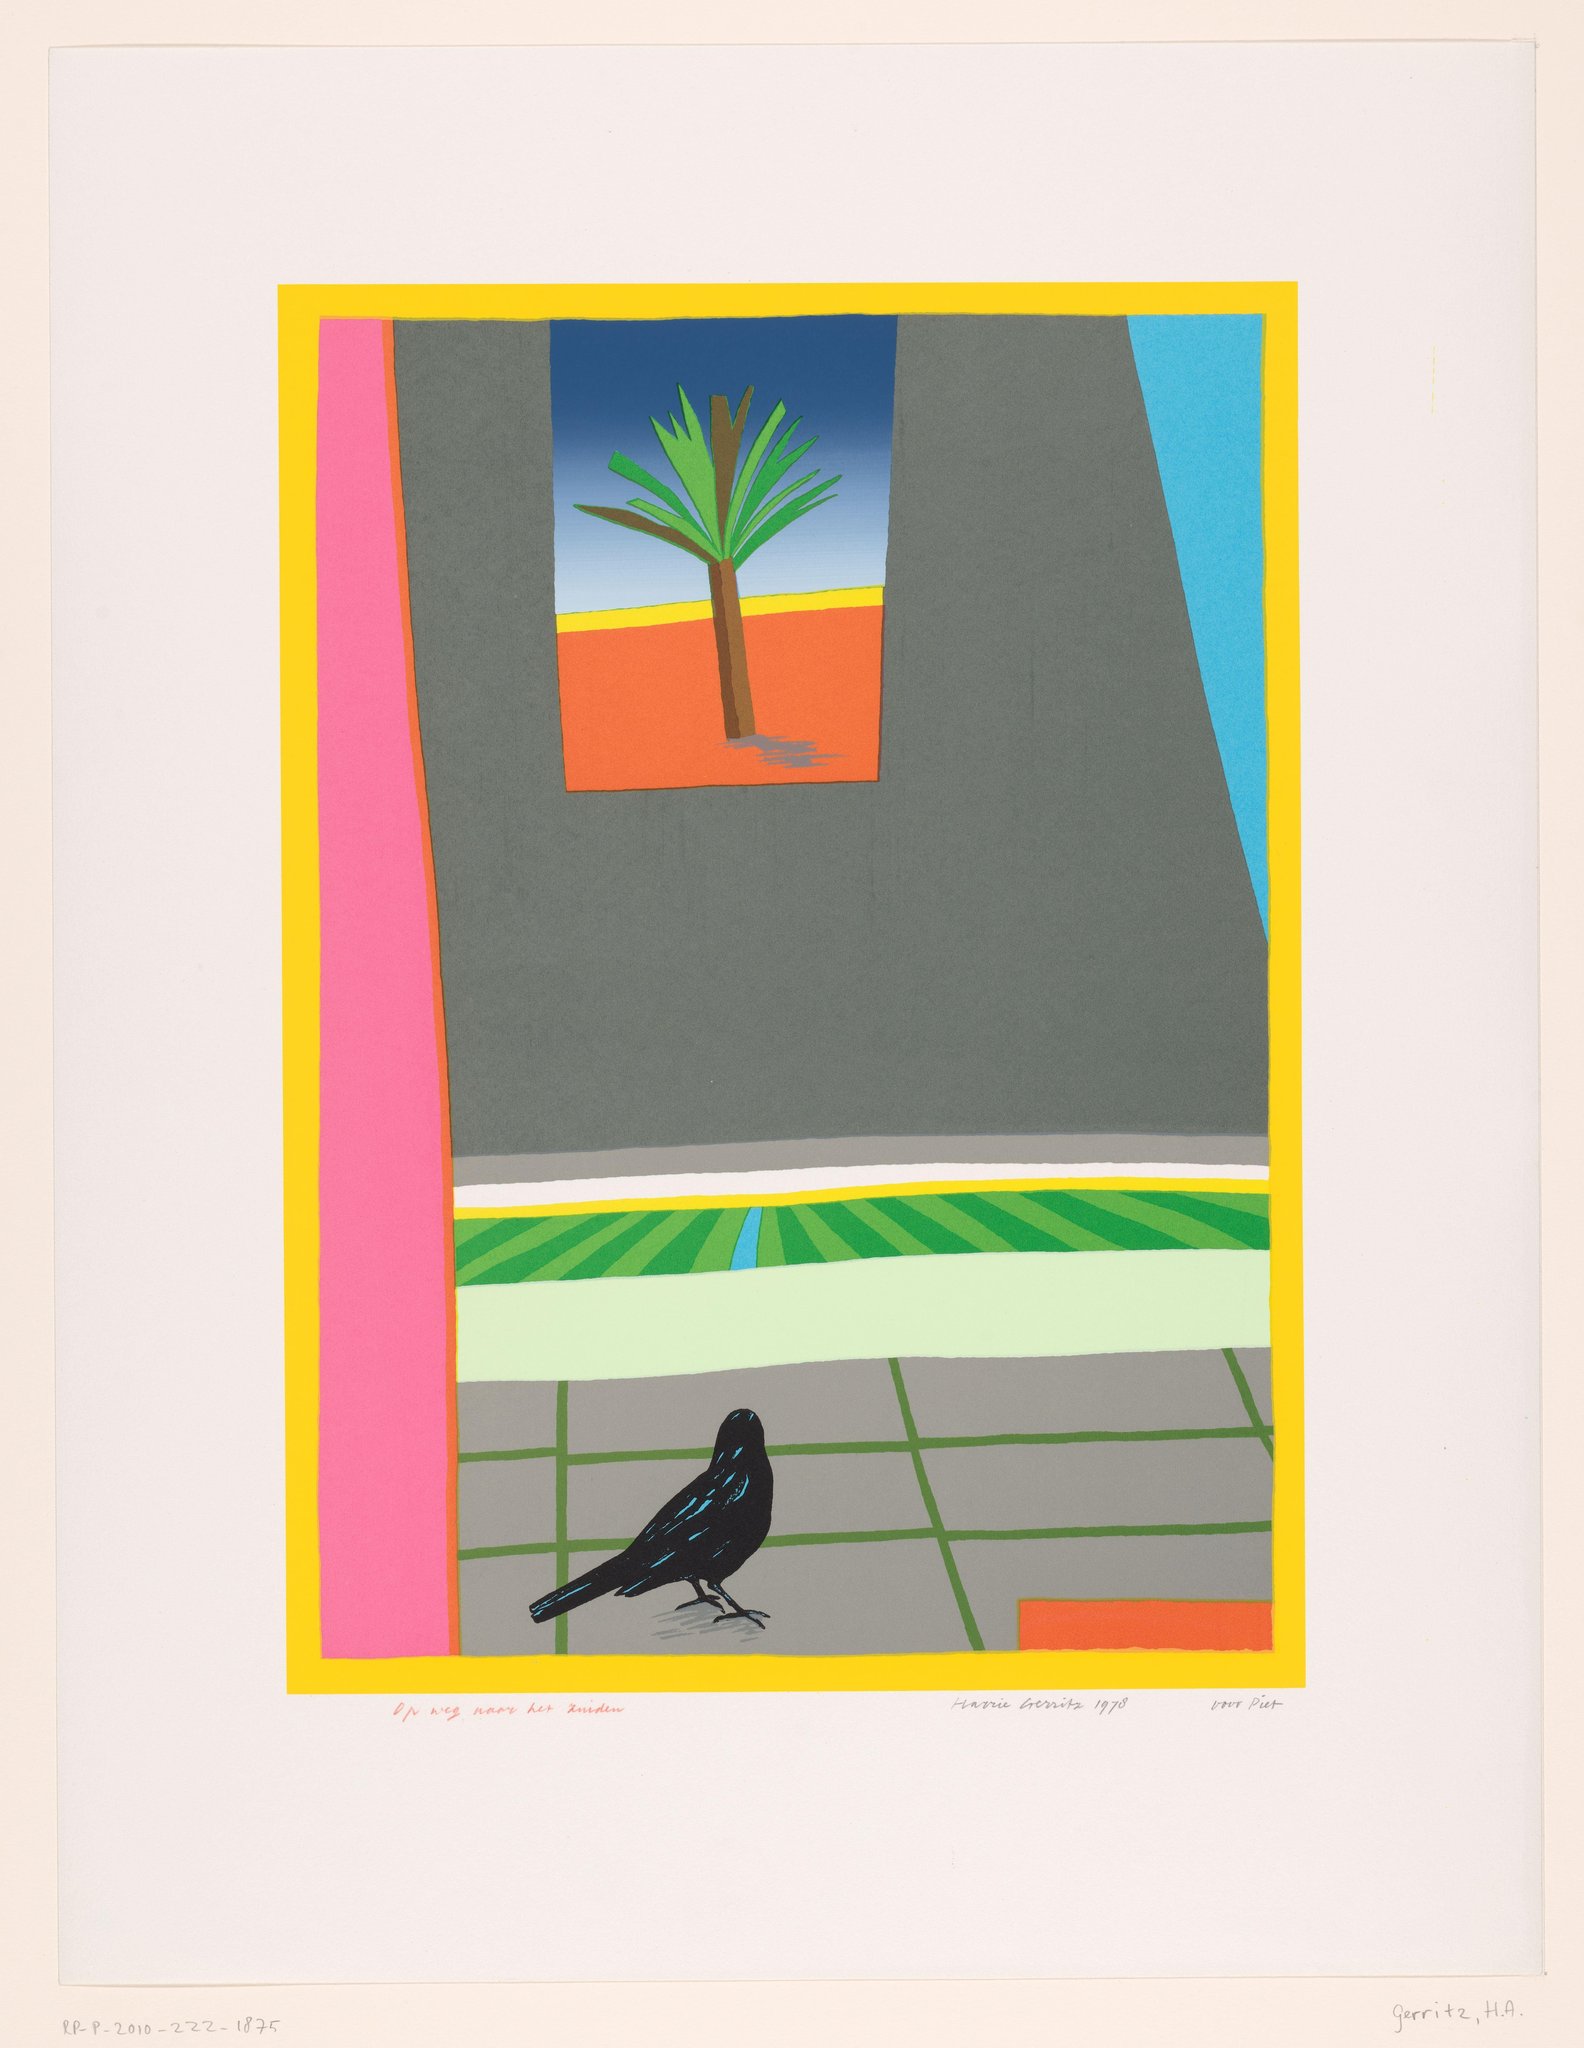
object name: print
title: Op weg naar het zuiden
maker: harrie a. gerritz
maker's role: draughtsman, painter, print maker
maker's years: 1940-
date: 1978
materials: paper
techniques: screen printing in color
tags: birds, trees: palm-tree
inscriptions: dedication: ‘voor Piet’, collector's mark: Lugt 2228, inscription: ‘PC’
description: Zwarte vogel kijkend naar een palmboom binnen een rechthoek.